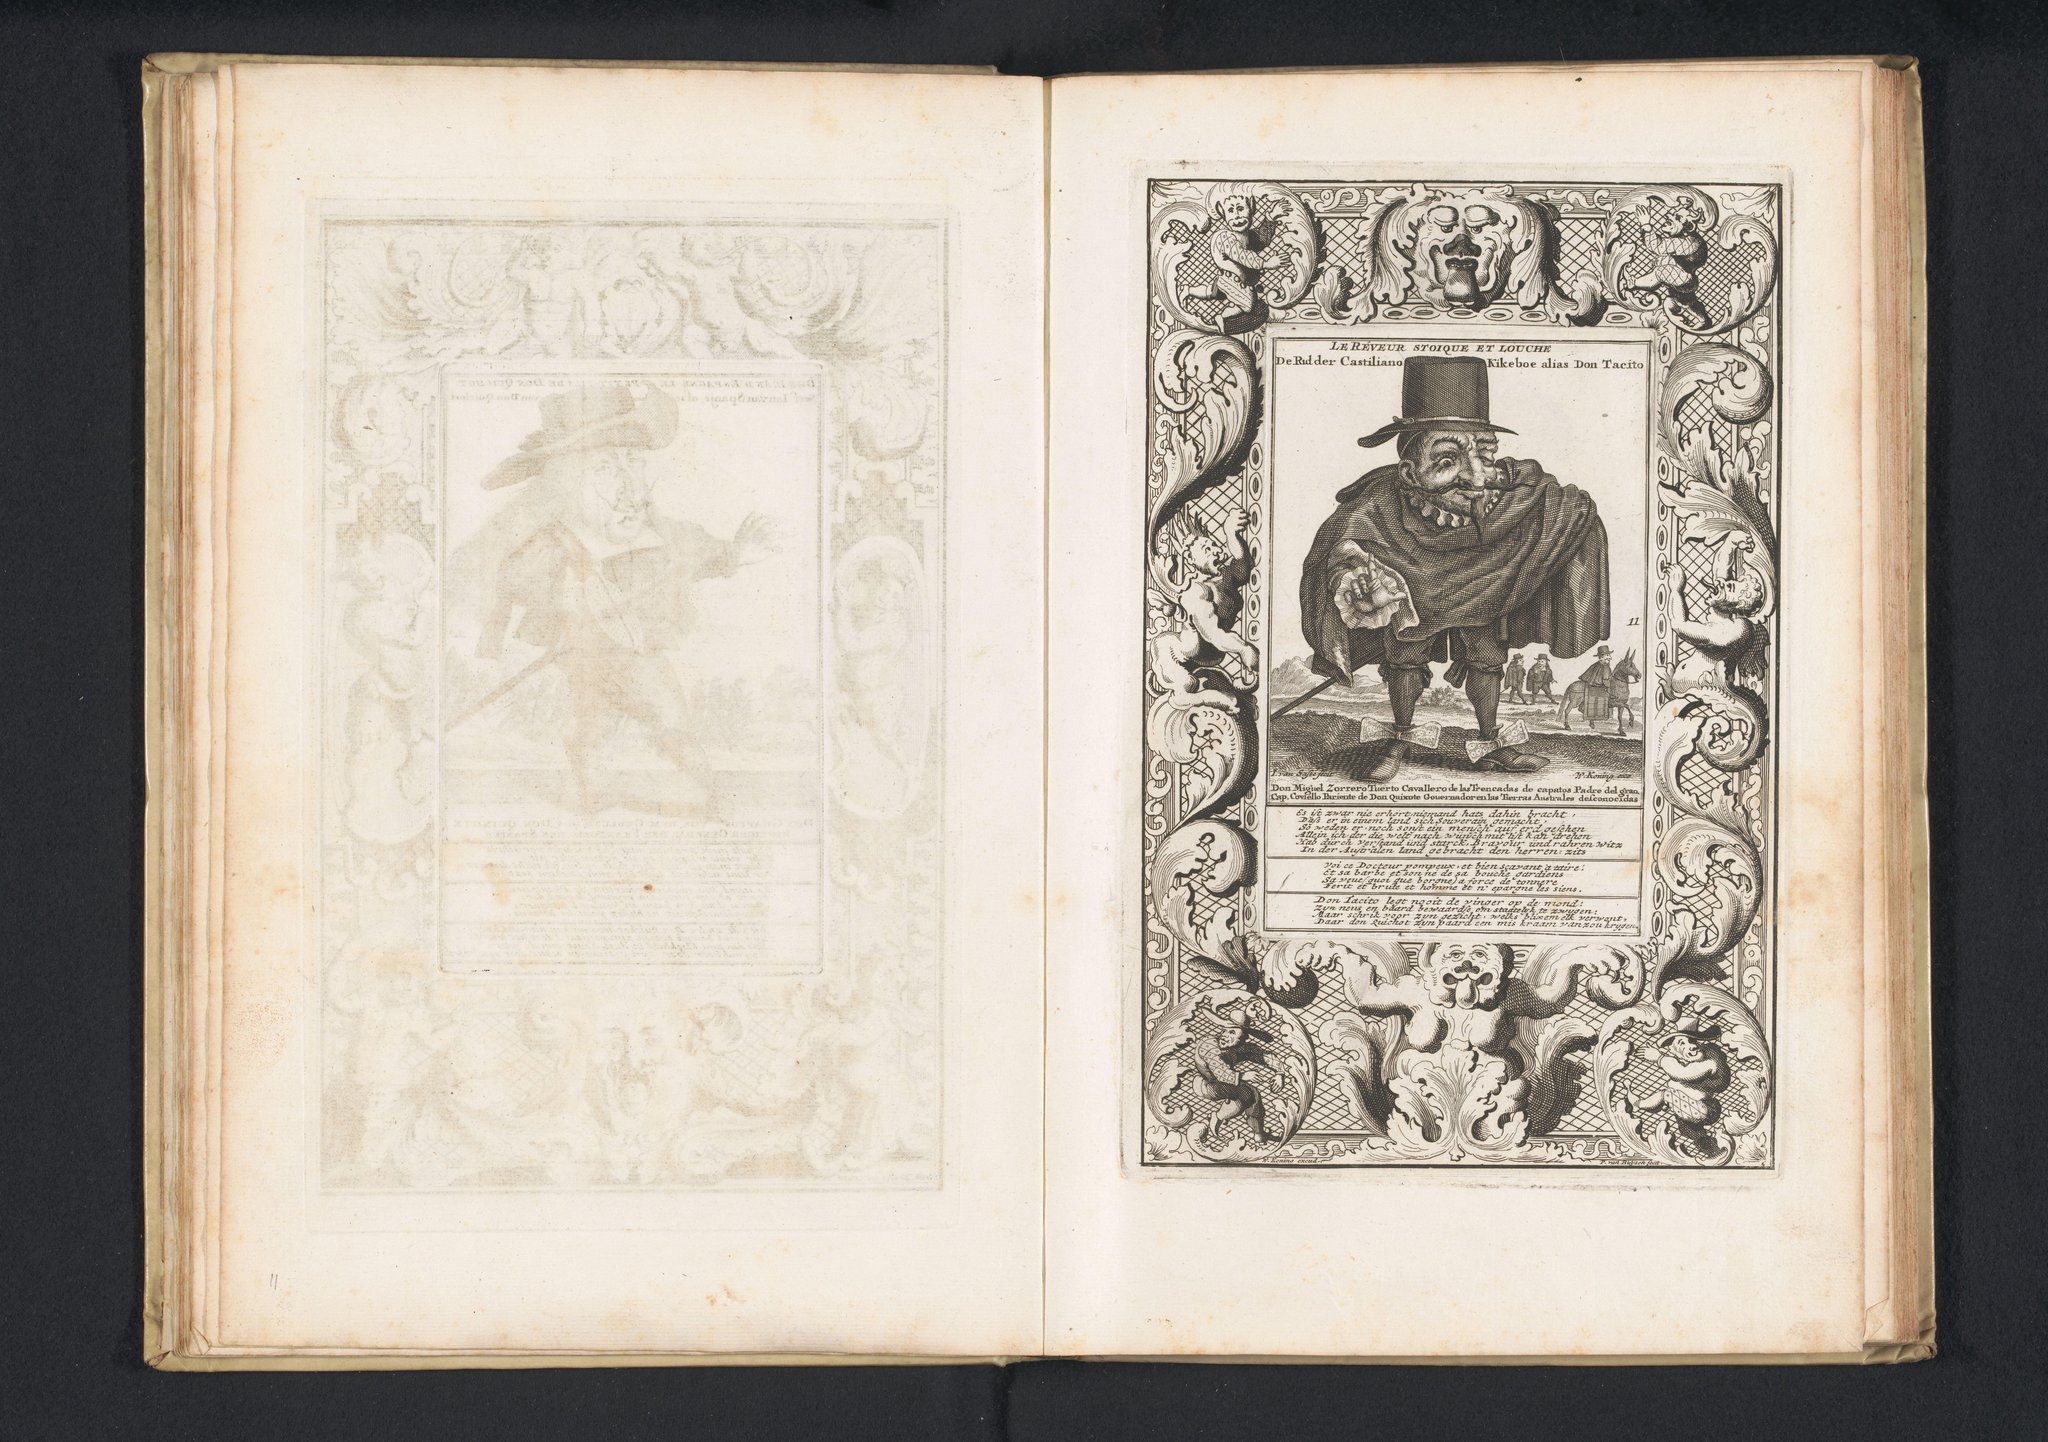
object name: print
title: Le Réveur stoique et louche / De Ridder Castiliano Kikeboe alias Don Tacito / Don Miguel Zorrero Tuerto Cavallero de las Trencadas de capatos, Padre del gran Cap. Covielllo Pariente de Don Quixote, Gouernador en las Tierras Australes desconocidas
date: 1716-1720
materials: paper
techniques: etching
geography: northern netherlands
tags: caricatures (human types), little people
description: De eenogige Spaanse kleine mens Ridder Castiliano Kikeboe. In het onderschrift verzen in het Duits, Frans en Nederlands. Genummerd rechts midden: 11. Afdruk binnen een decoratieve omlijsting gedrukt van een aparte plaat met bladeren en harlekijnen. Onderdeel van de tweede Nederlandse gebonden uitgave uit 1720 (en gerelateerd aan de Windhandel in dat jaar) van een serie karikaturen van kleine mensen, bekend als Het Dwergentooneel, deels gekopieerd naar een ouder Duits voorbeeld.